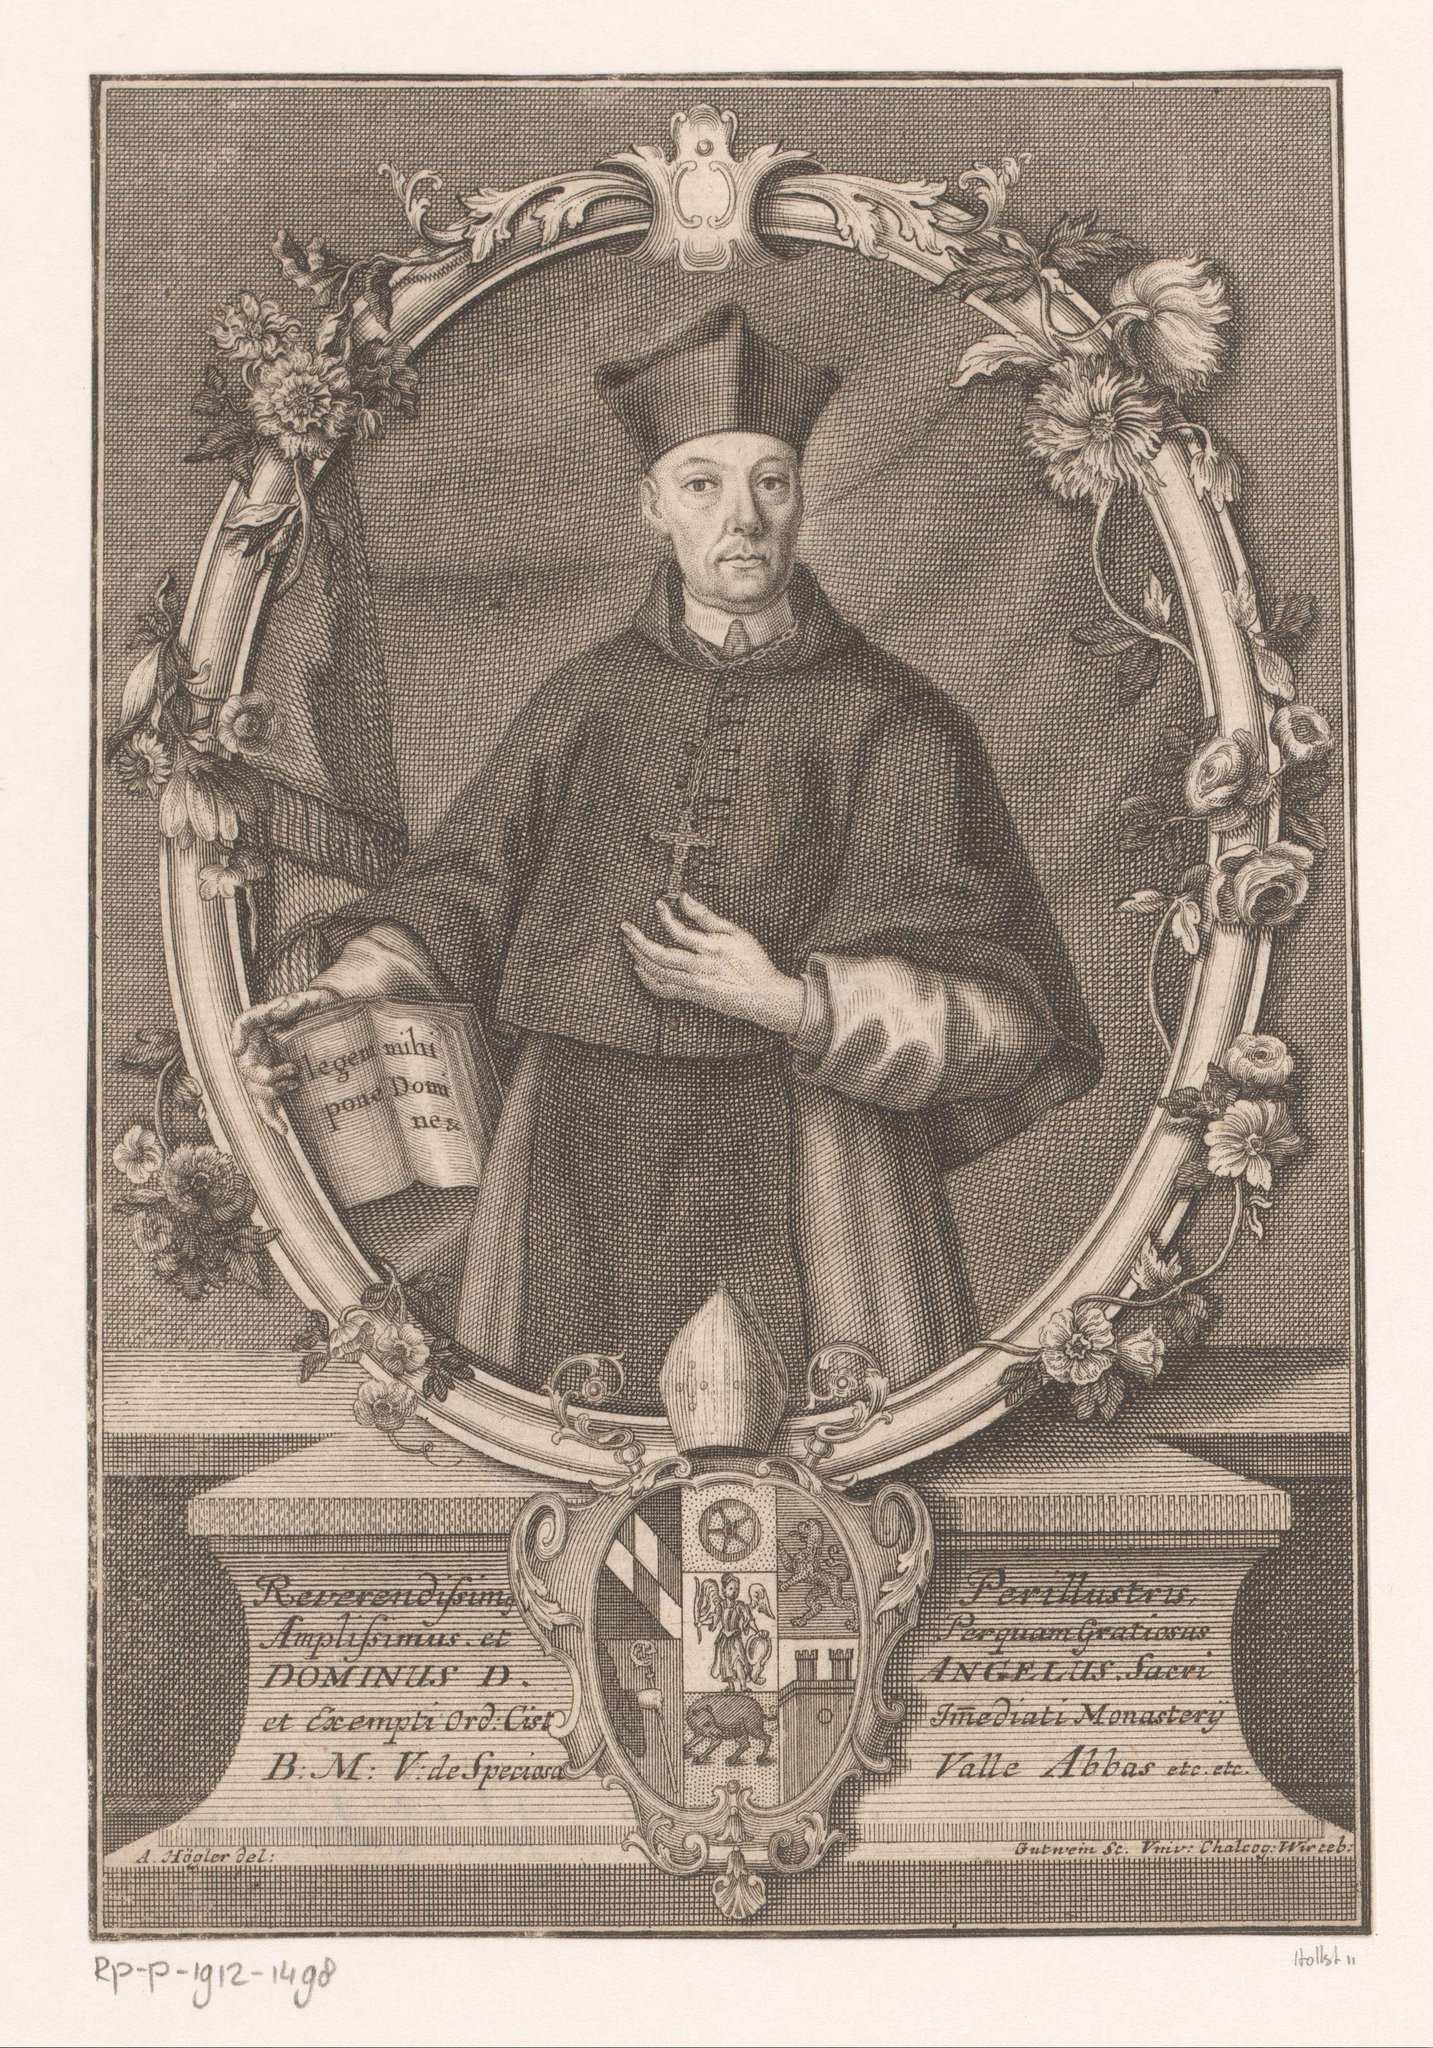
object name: print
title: Portret van de cisterciënzer abt Angelus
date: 1669-1730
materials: paper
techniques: engraving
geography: würzburg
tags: flowers, insignia of bishop, e.g. mitre, crozier, ornament ~ medallion, historical persons, book, armorial bearing, heraldry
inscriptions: collector's mark: Lugt 2228